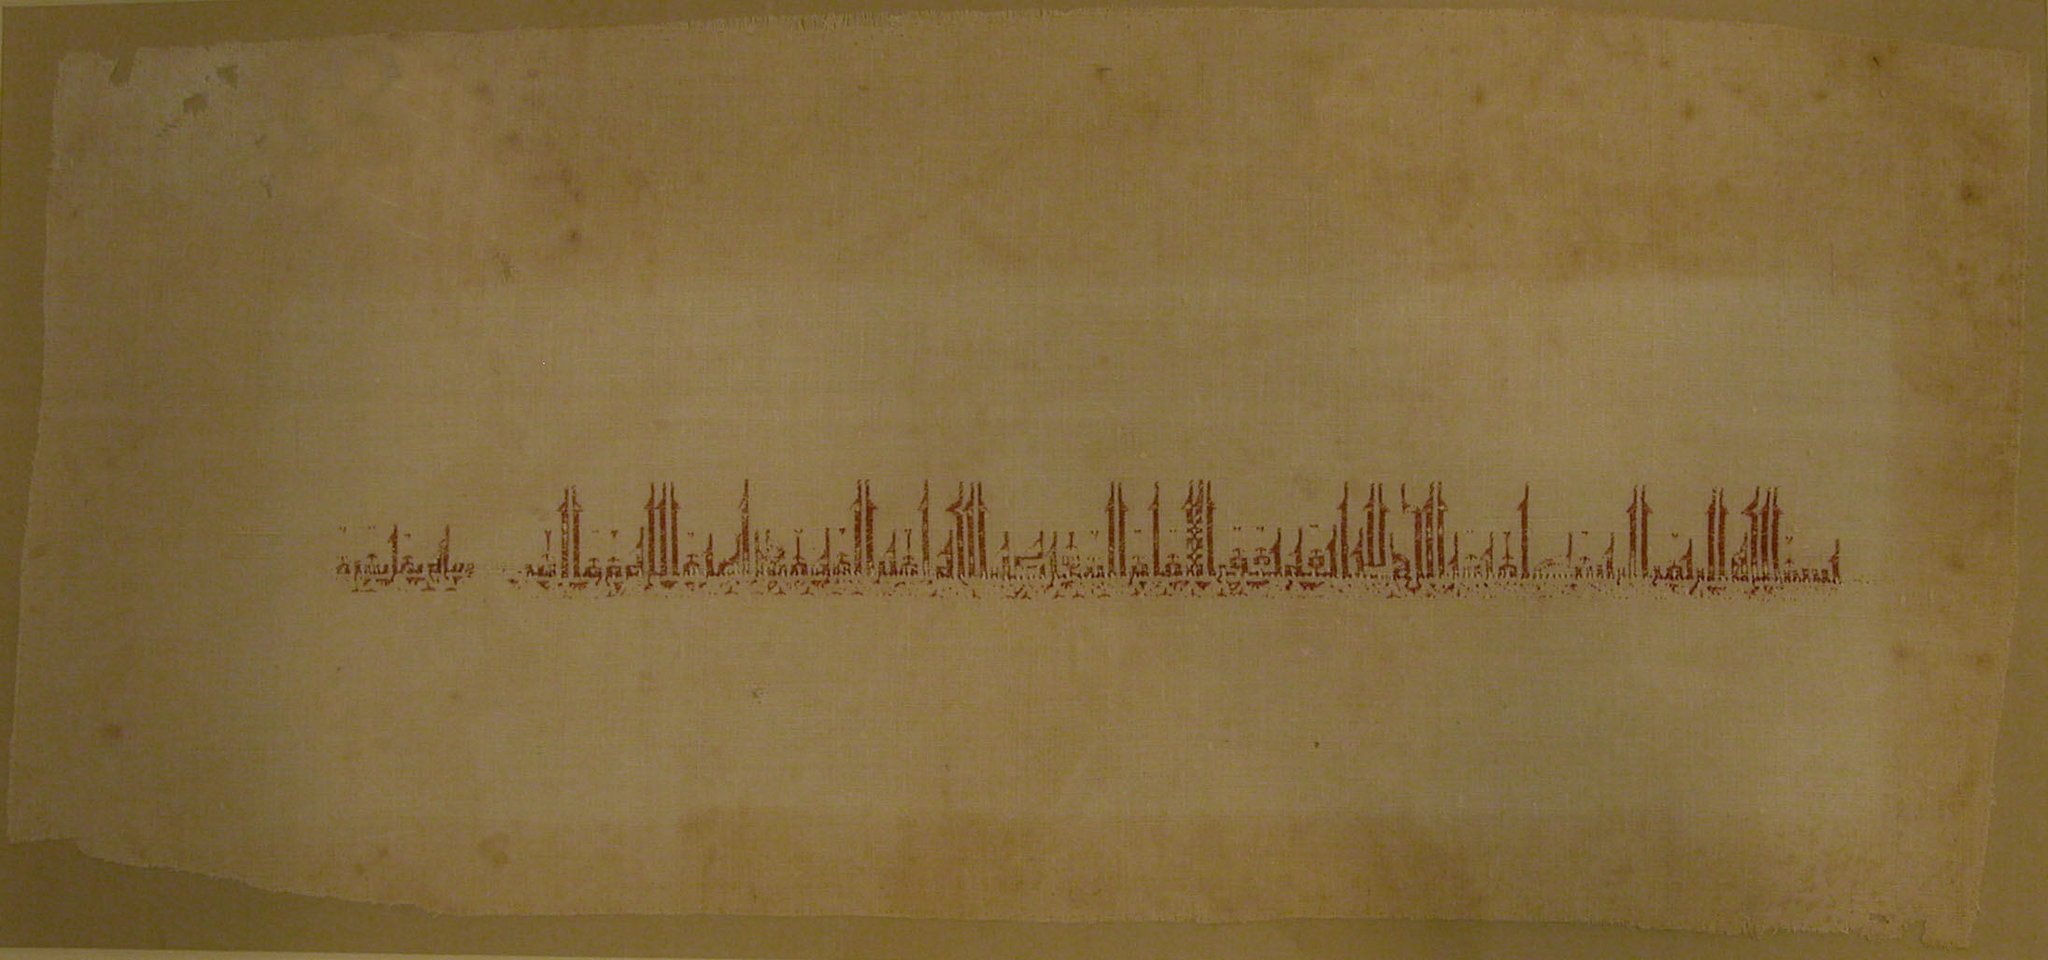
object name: textile fragment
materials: linen, silk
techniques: embroidery, weave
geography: iraq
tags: arabic